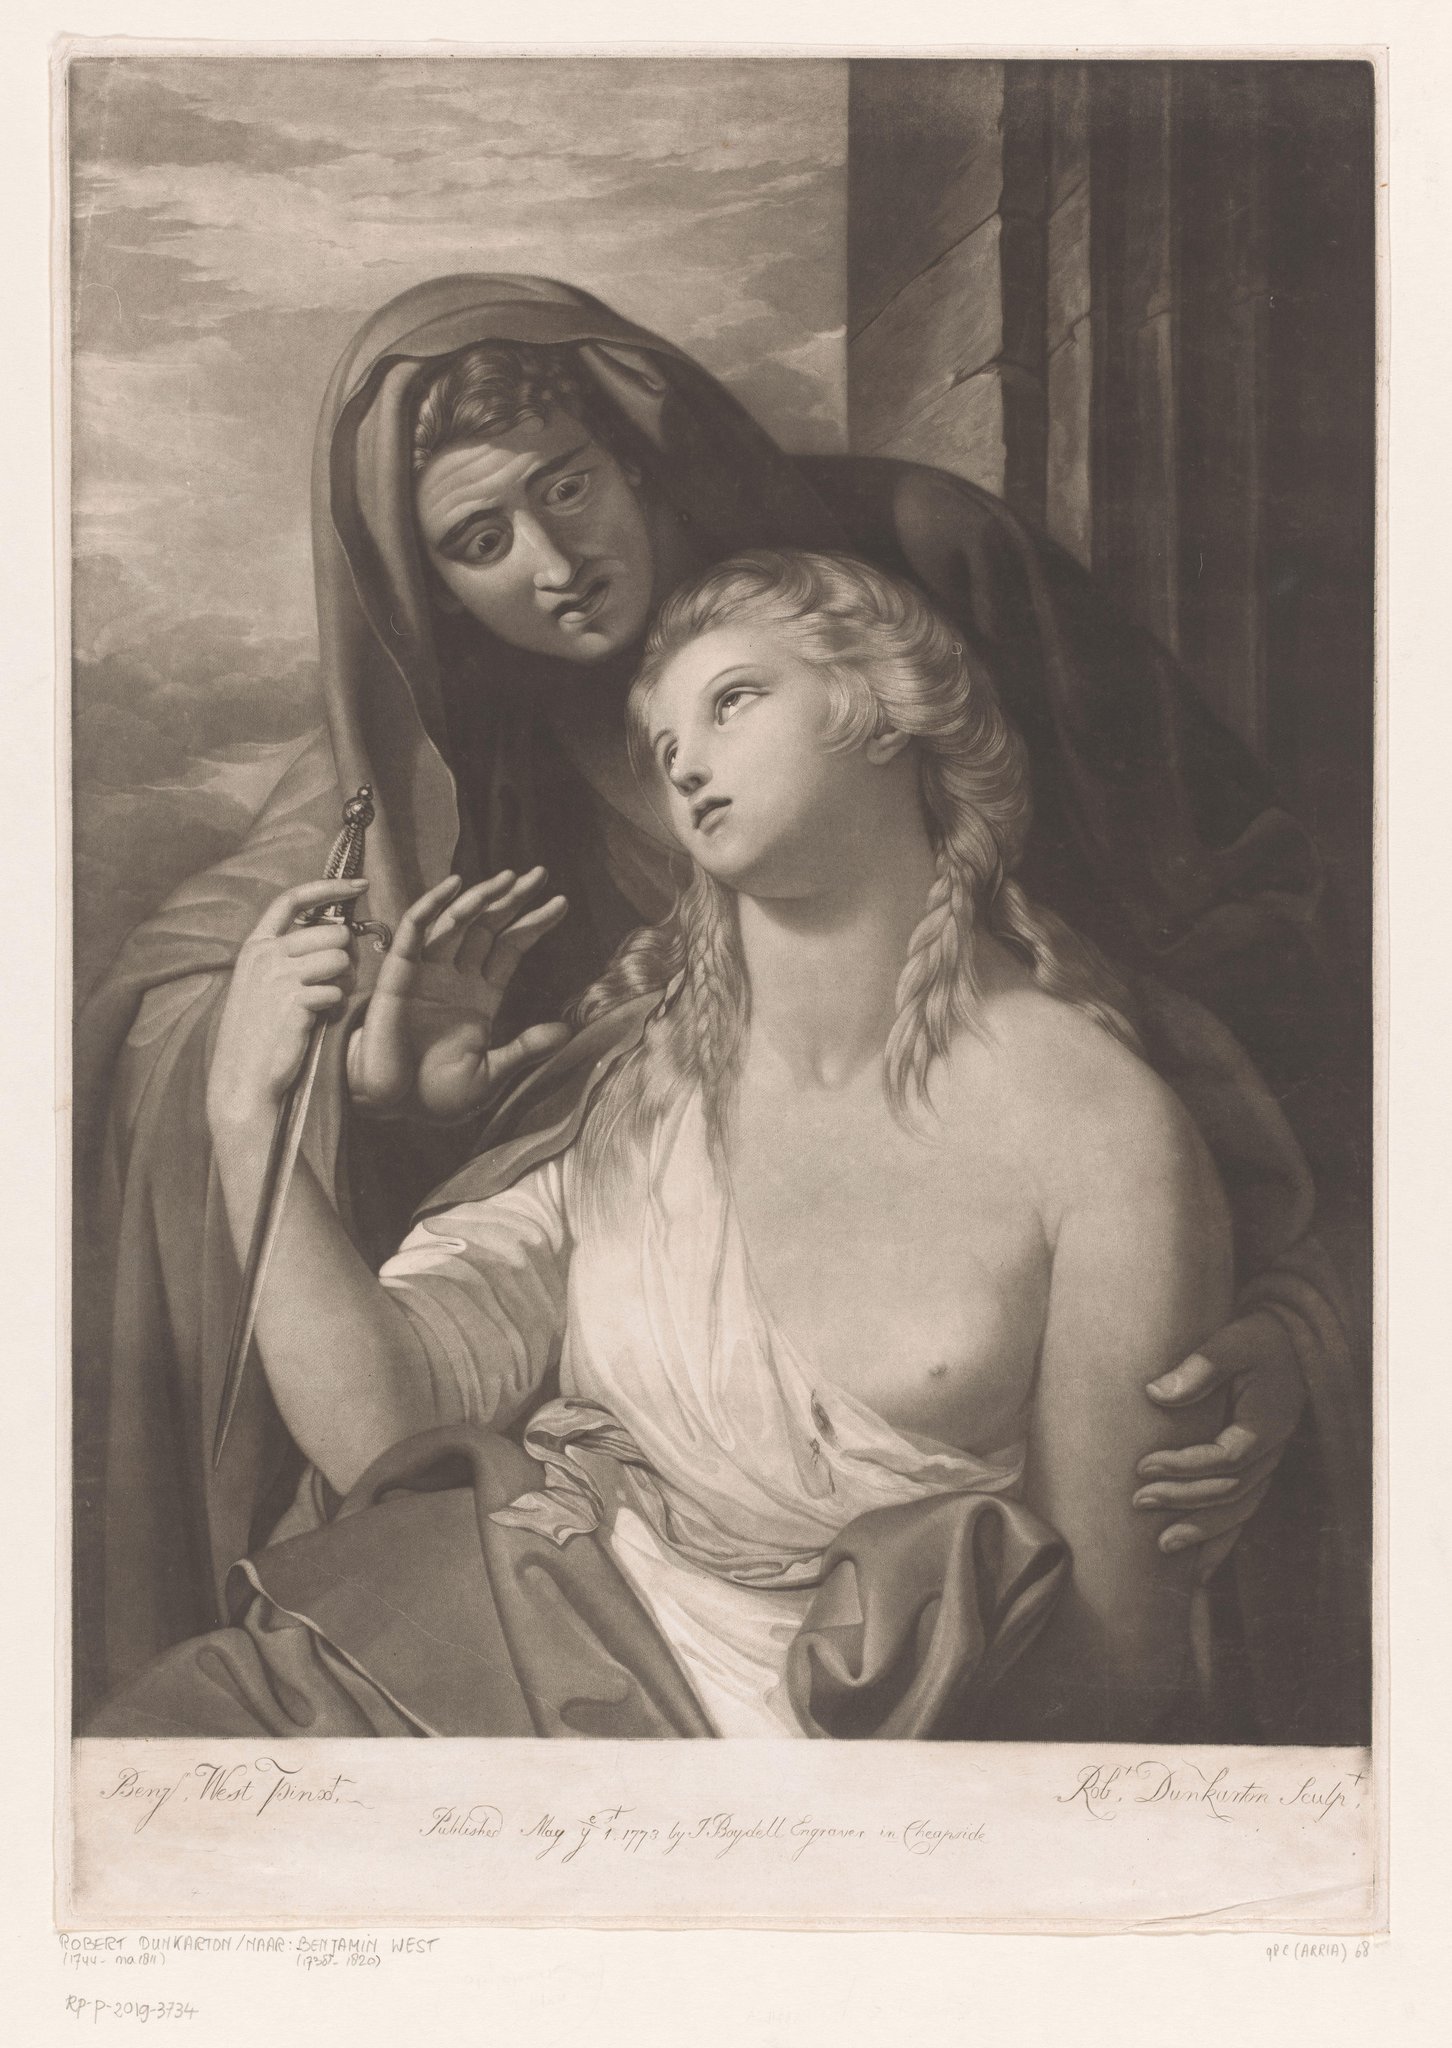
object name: print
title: Pætus and Arria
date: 1773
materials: paper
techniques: mezzotint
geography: london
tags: female persons from classical history (aria) - death of person from classical history, death of arria: to show her husband how to die she stabs herself and hands her husband the dagger with the words 'paete non dolet'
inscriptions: collector's mark: Lugt 2228